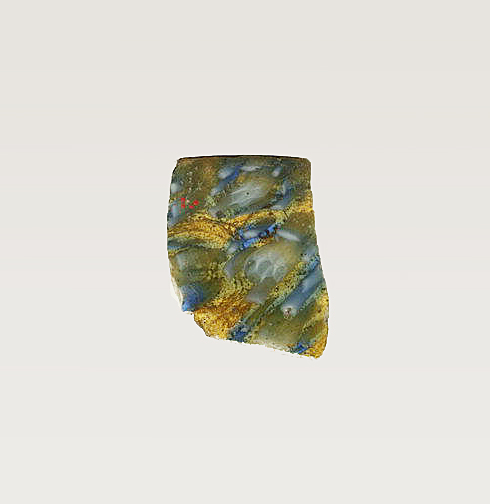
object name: fragment, mosaic bowl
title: Glass mosaic fragment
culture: roman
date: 34 BCE-33 CE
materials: glass